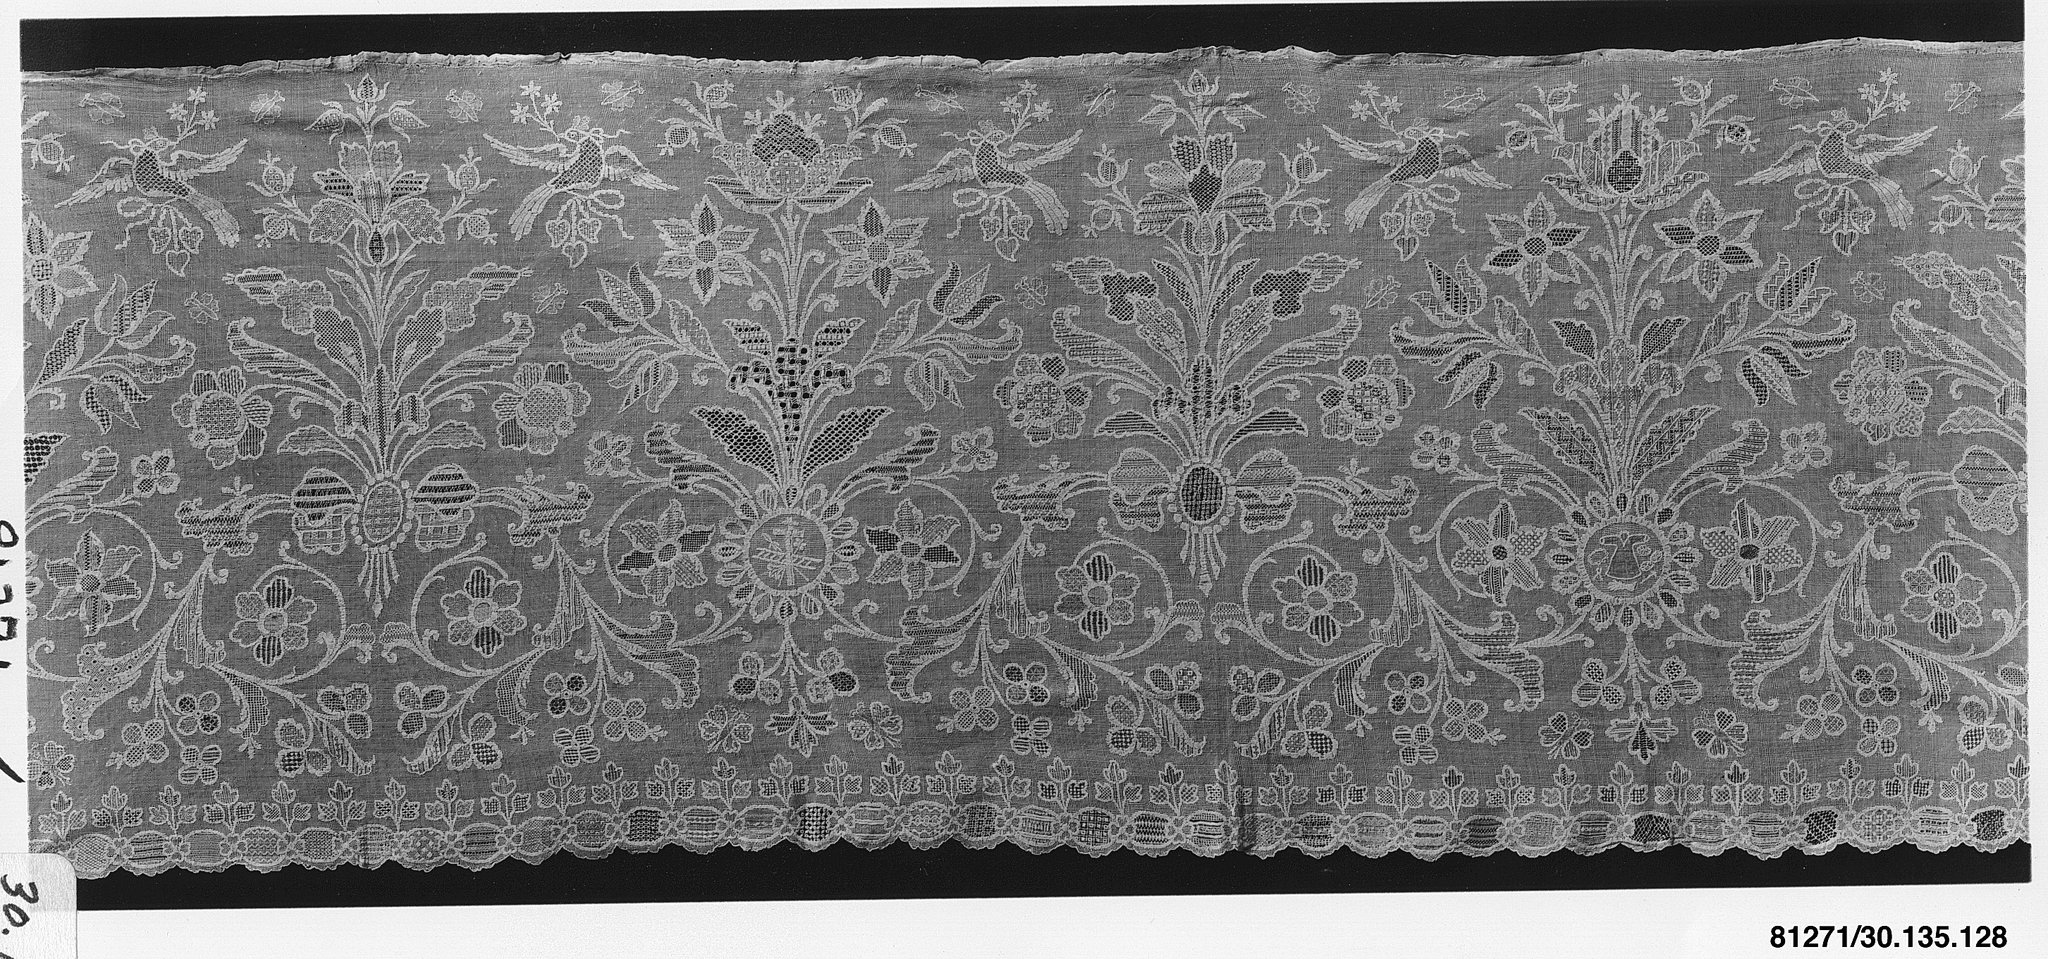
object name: altar frontal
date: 1701-1800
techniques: embroidery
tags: flowers